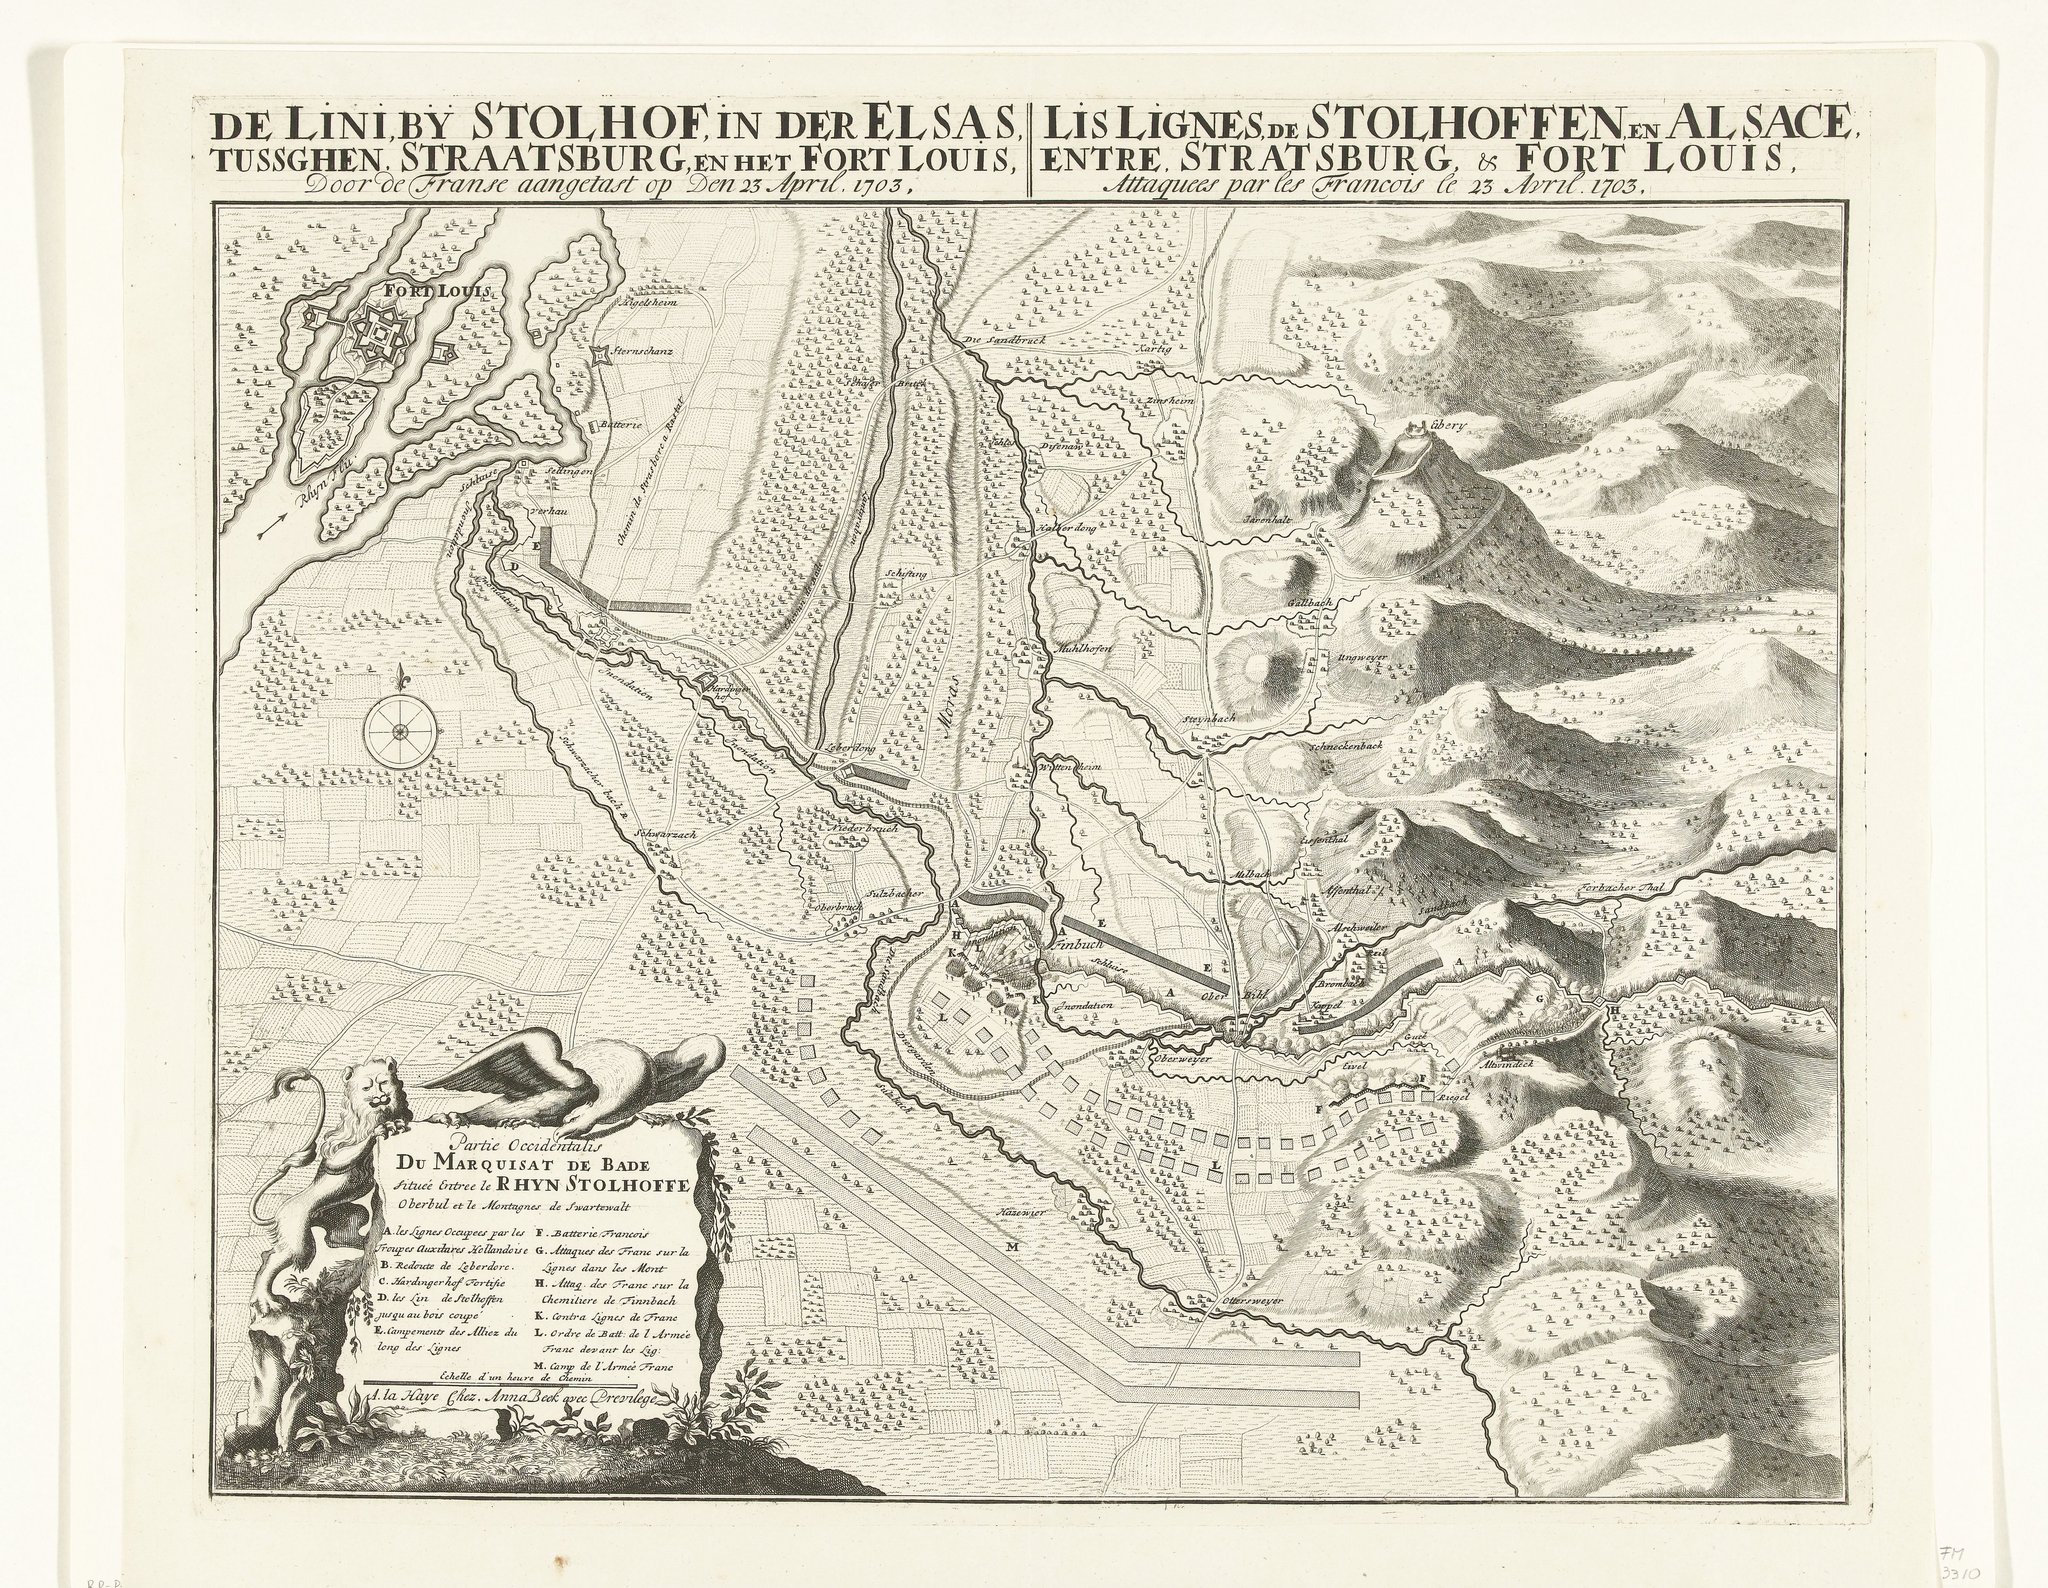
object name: map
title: De Lini, by Stolhof, in der Elsas, tussghen, Straatsburg, en het Fort Louis, Door de Franse aangetast op Den 23 April, 1703 / Lis Lignes, de Stolhoffen en Alsace, entre, Strasburg, & Fort Louis, Attaquees par les Francois le 23 Avril 1703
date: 1703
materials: paper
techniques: etching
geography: the hague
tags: maps of separate countries or regions, battle (+ land forces)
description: Kaart van de linie bij Stollhofen bij Fort Louis aan de Rijn, aangevallen door de Fransen op 23 april 1703. Linksonder een cartouche met de Duitse adelaar en de Nederlandse Leeuw bij de legenda A-M.